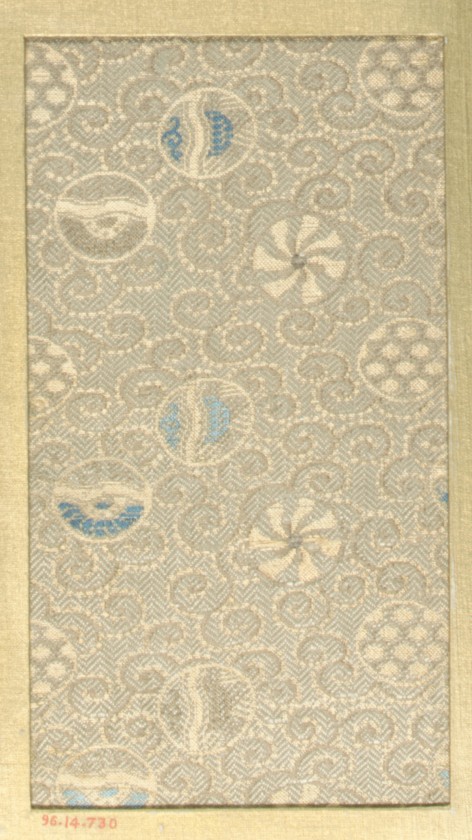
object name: piece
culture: japanese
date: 1701-1900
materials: silk